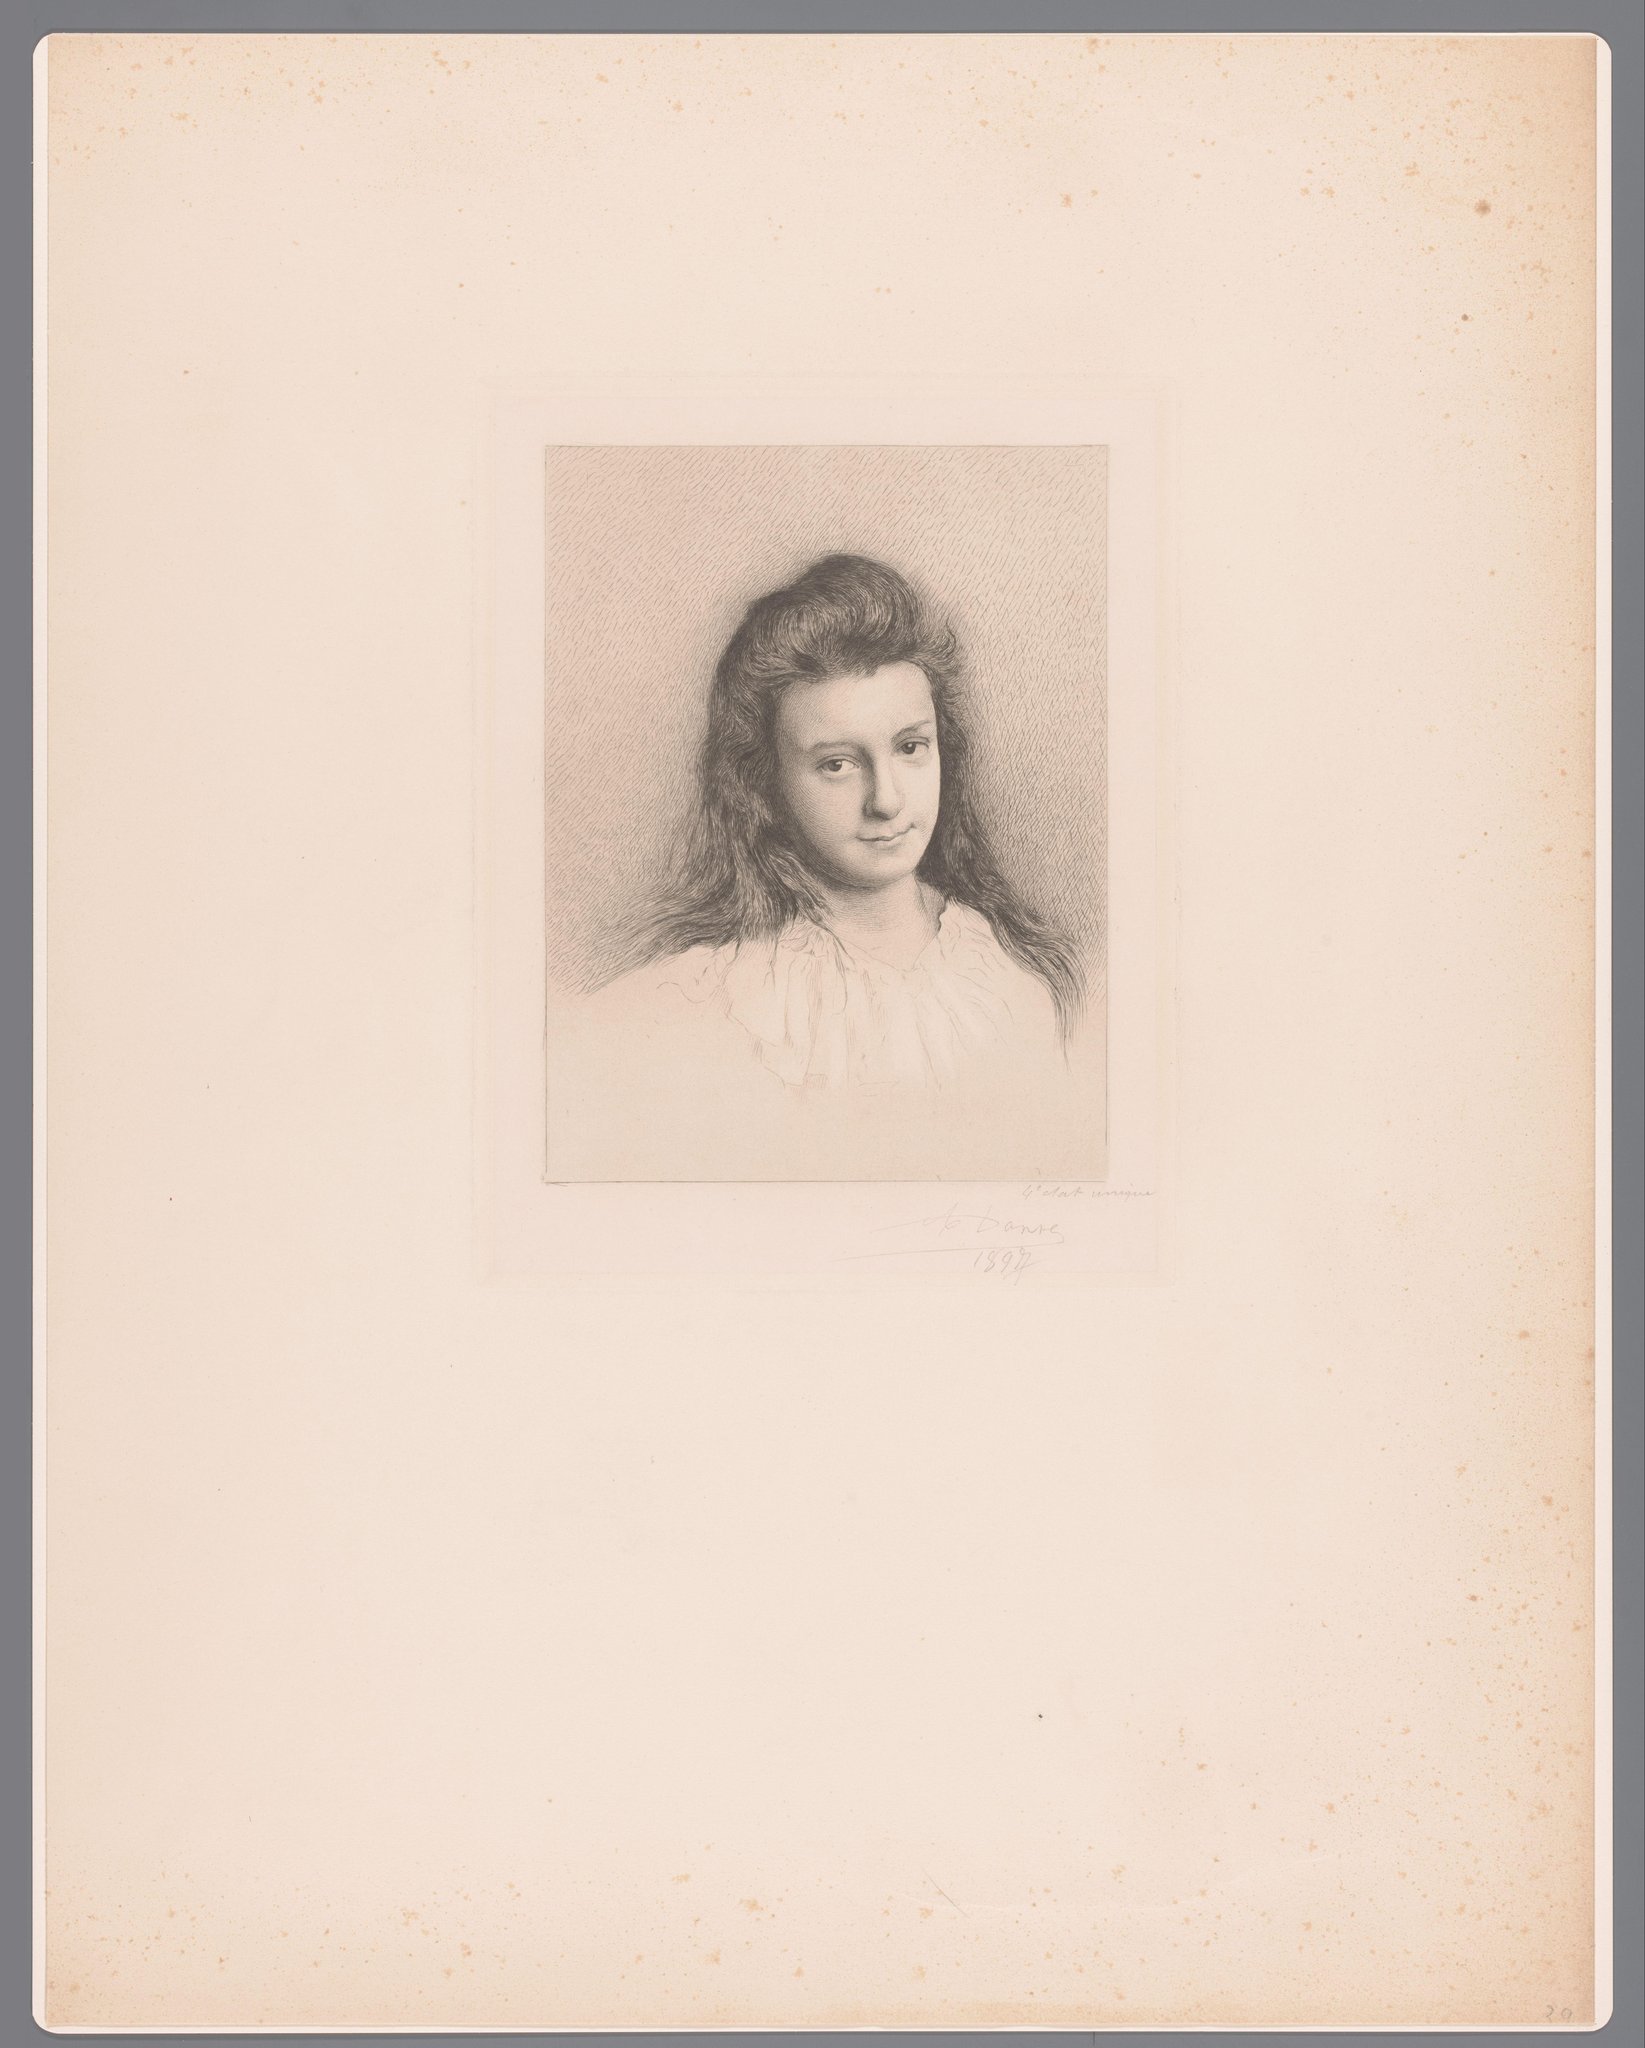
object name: print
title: Portret van de dochter van Victor-Charles Mahillon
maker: auguste danse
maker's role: print maker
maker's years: 1829-1929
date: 1897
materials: paper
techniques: drypoint, etching, intaglio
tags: historical person (with name) - bb - woman - historical person (with name) portrayed alone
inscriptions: collector's mark: Lugt 2228, annotation: ‘4e etat unique’